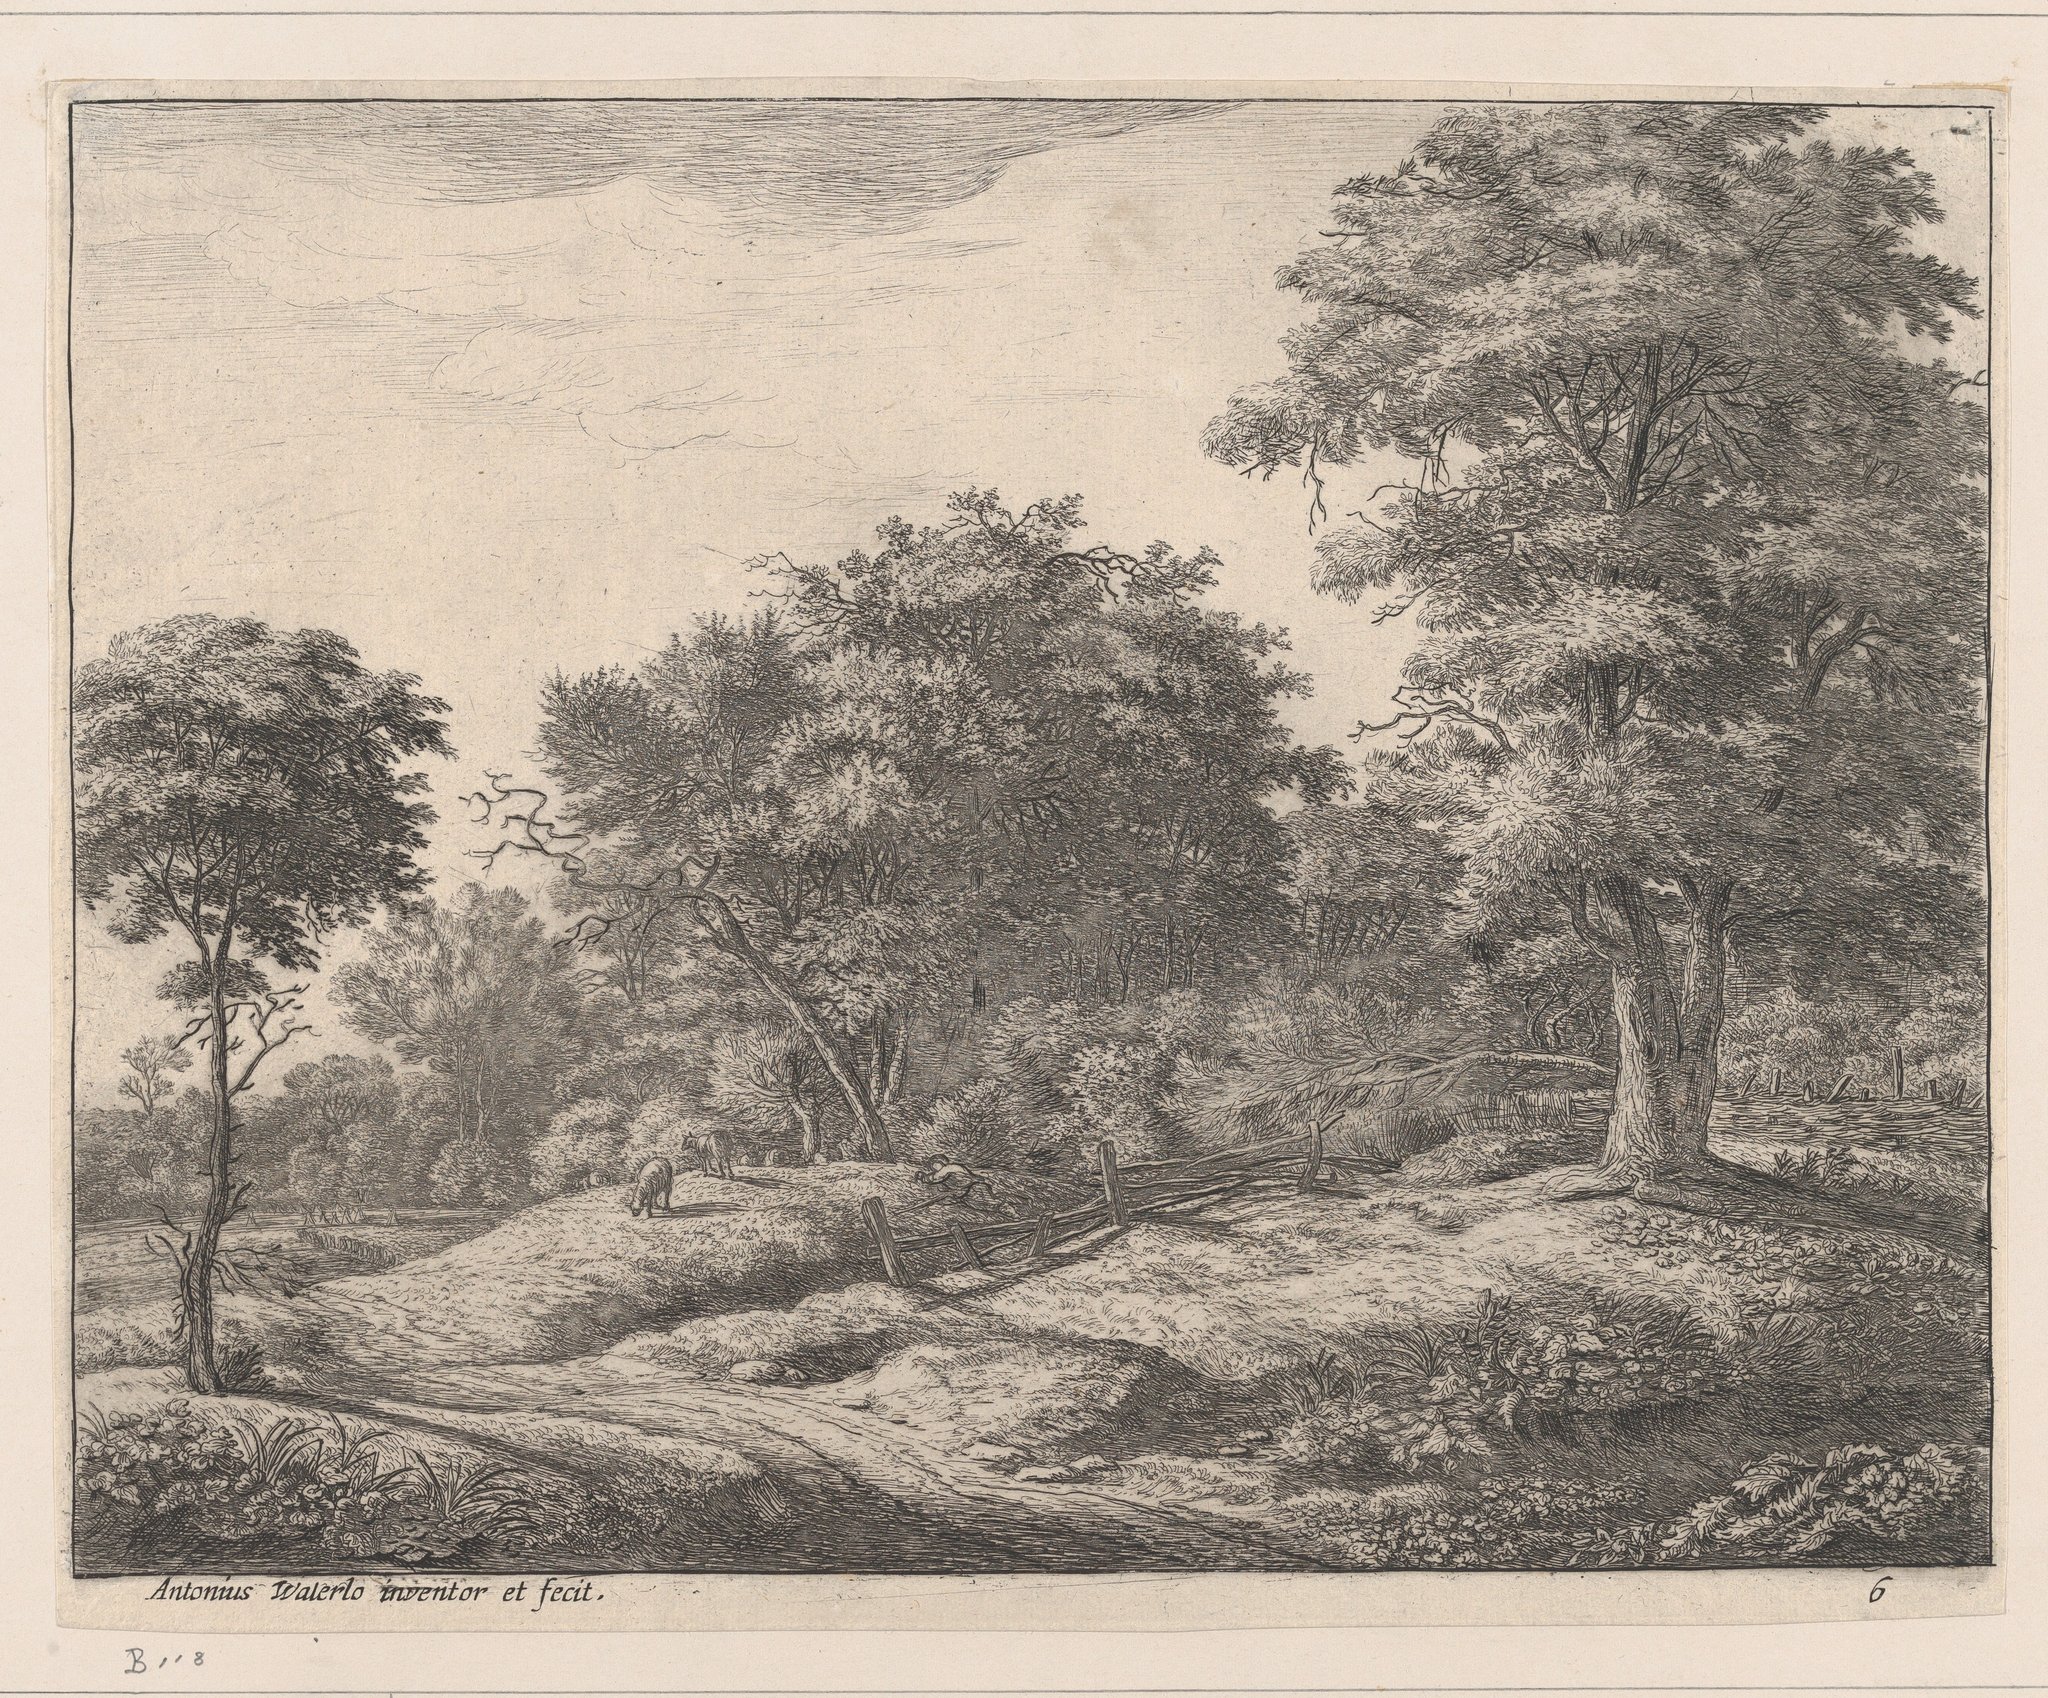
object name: print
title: Shepherd Asleep on a Hummock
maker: anthonie waterloo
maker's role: artist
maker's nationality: dutch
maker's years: 1609-1690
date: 1601-1700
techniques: etching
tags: animals,trees,shepherds